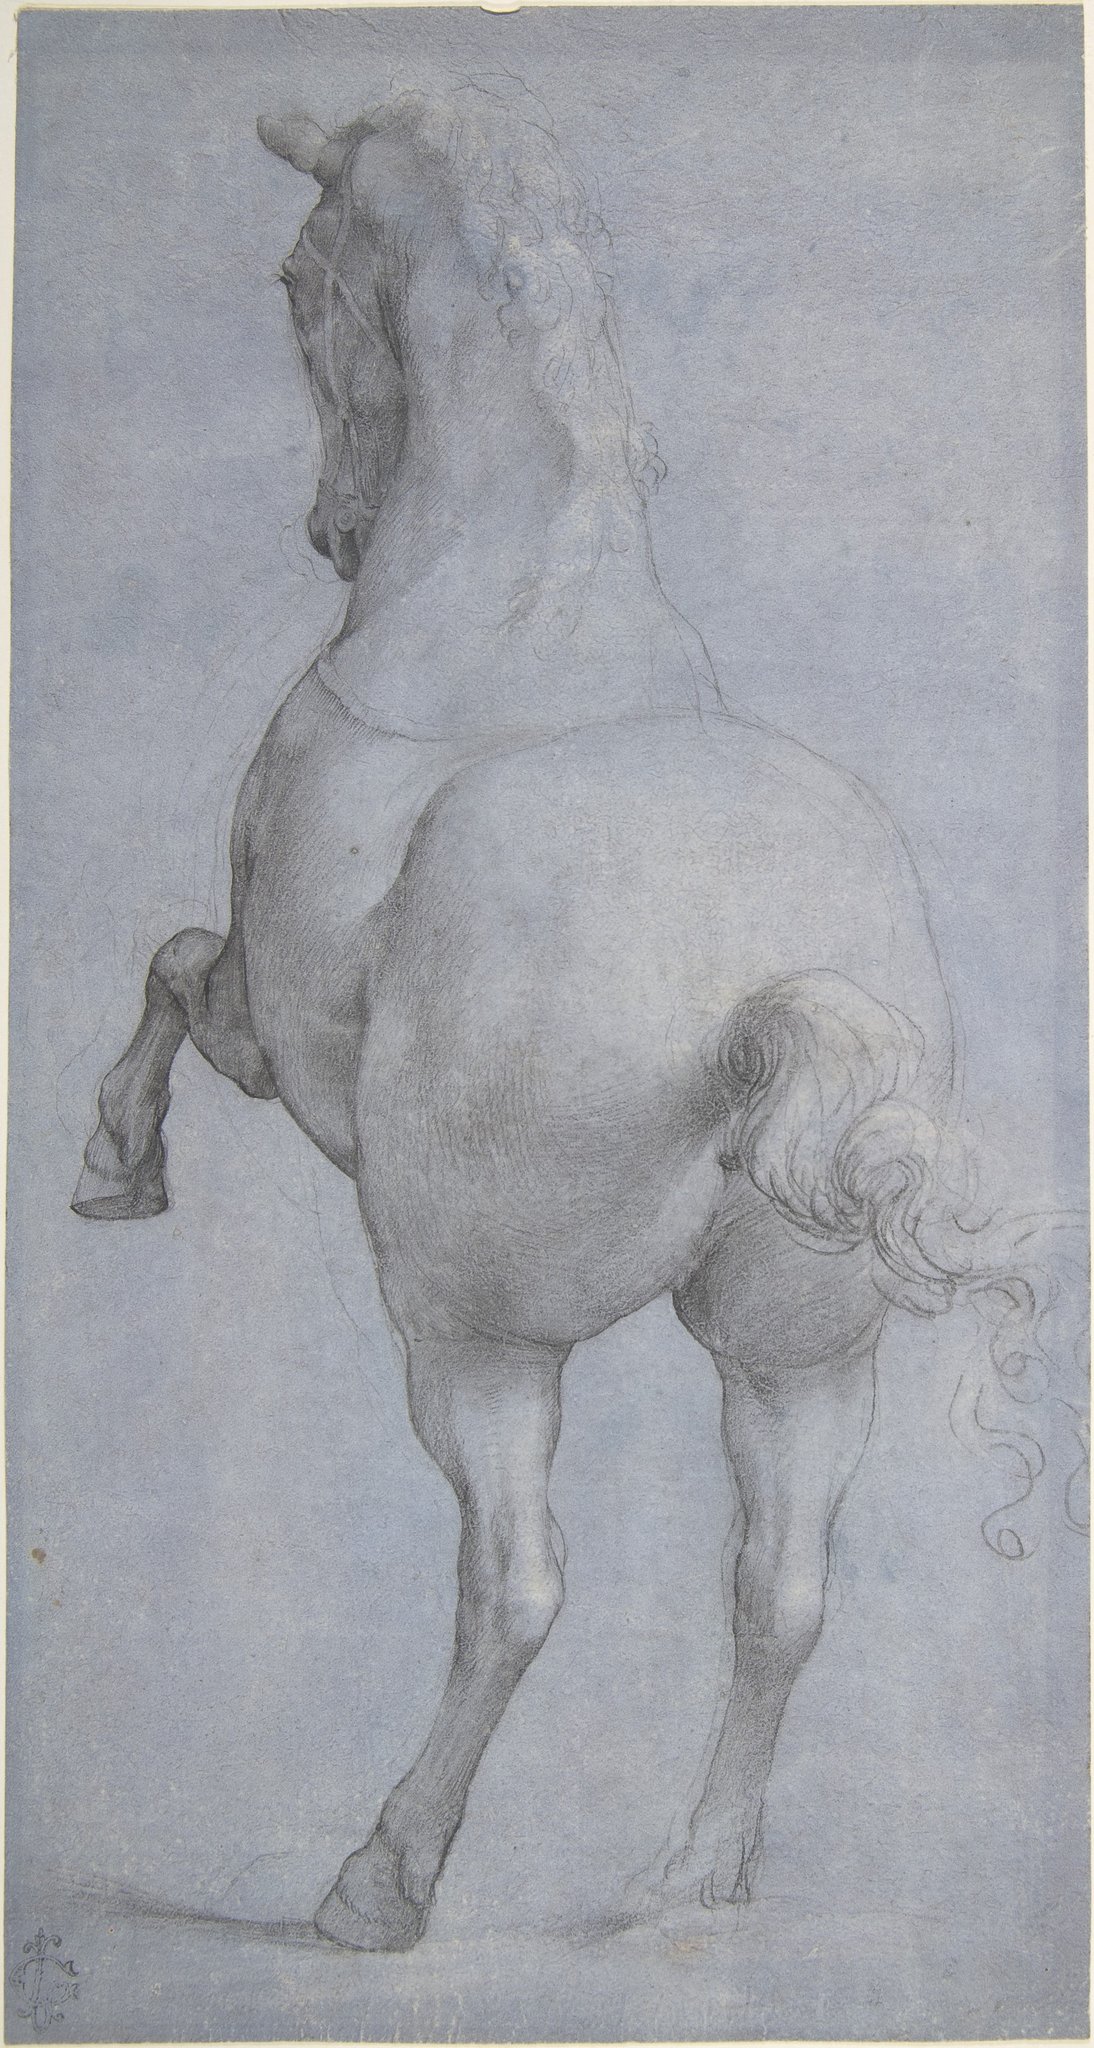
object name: drawing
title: Rearing Horse in Rear Three-Quarter View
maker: anonymous, italian, florentine, 16th century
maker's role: artist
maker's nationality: italian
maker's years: 1500-1600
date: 1501-1600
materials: chalk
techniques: wash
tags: horses